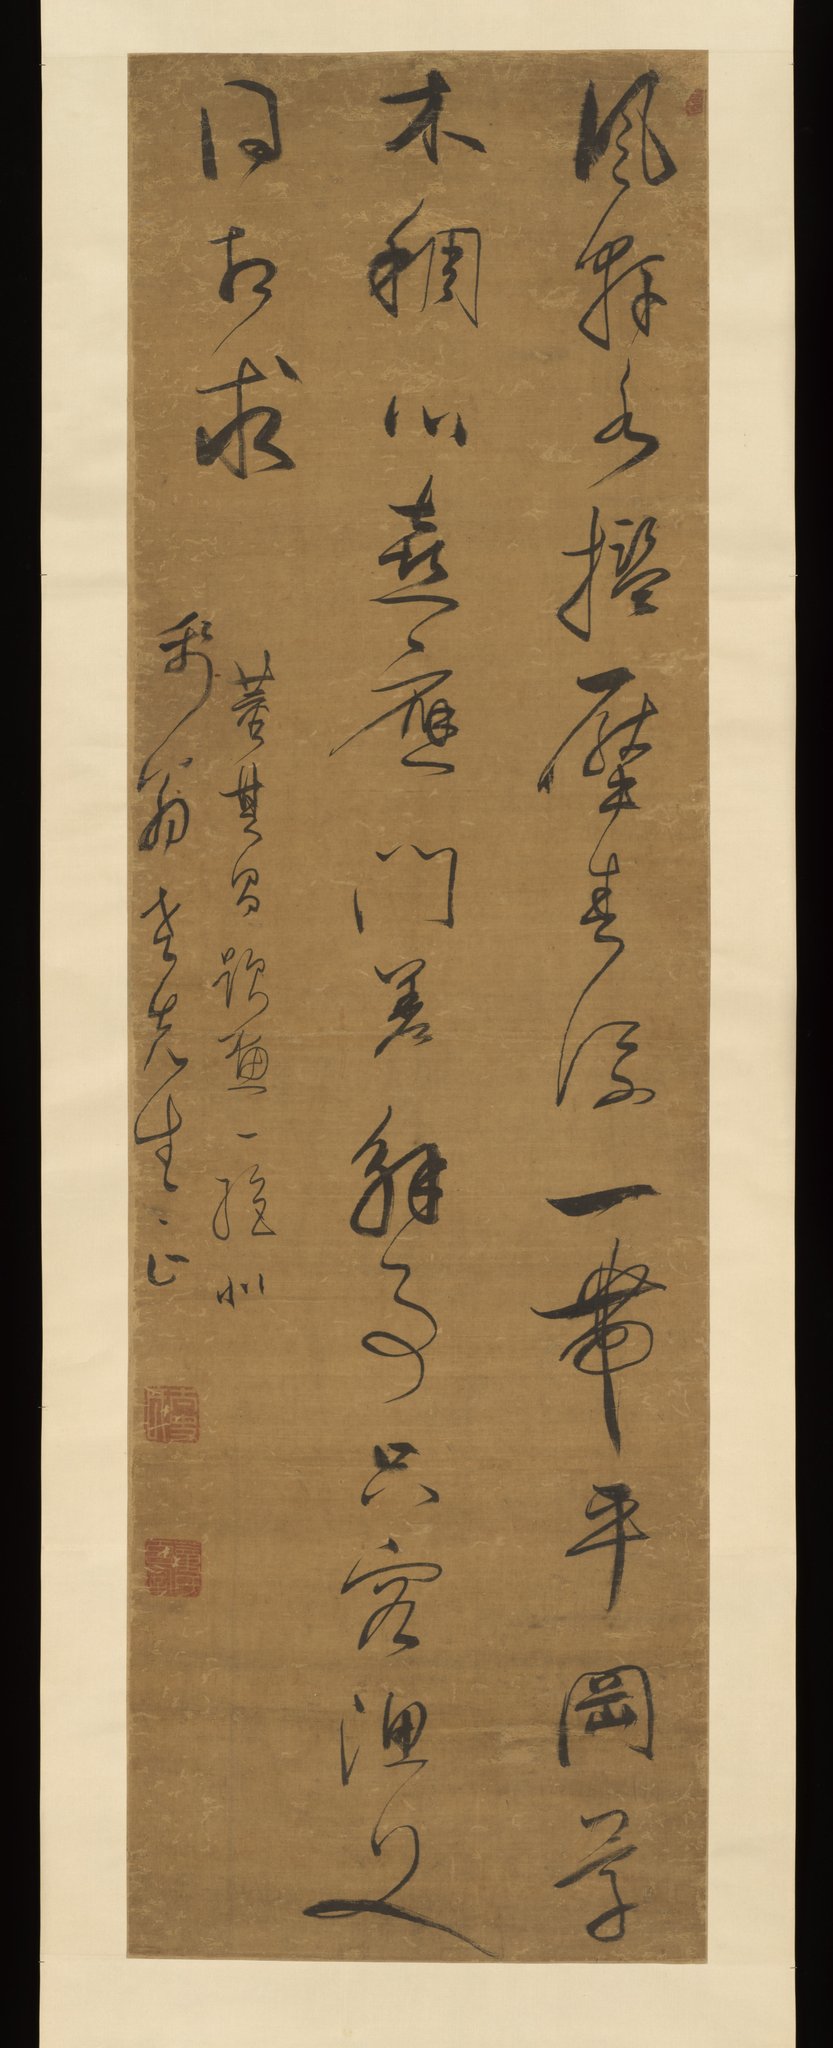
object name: hanging scroll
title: Poem in Cursive Script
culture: chinese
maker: dong qichang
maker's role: artist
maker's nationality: chinese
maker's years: 1555-1636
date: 1622-1625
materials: ink, silk